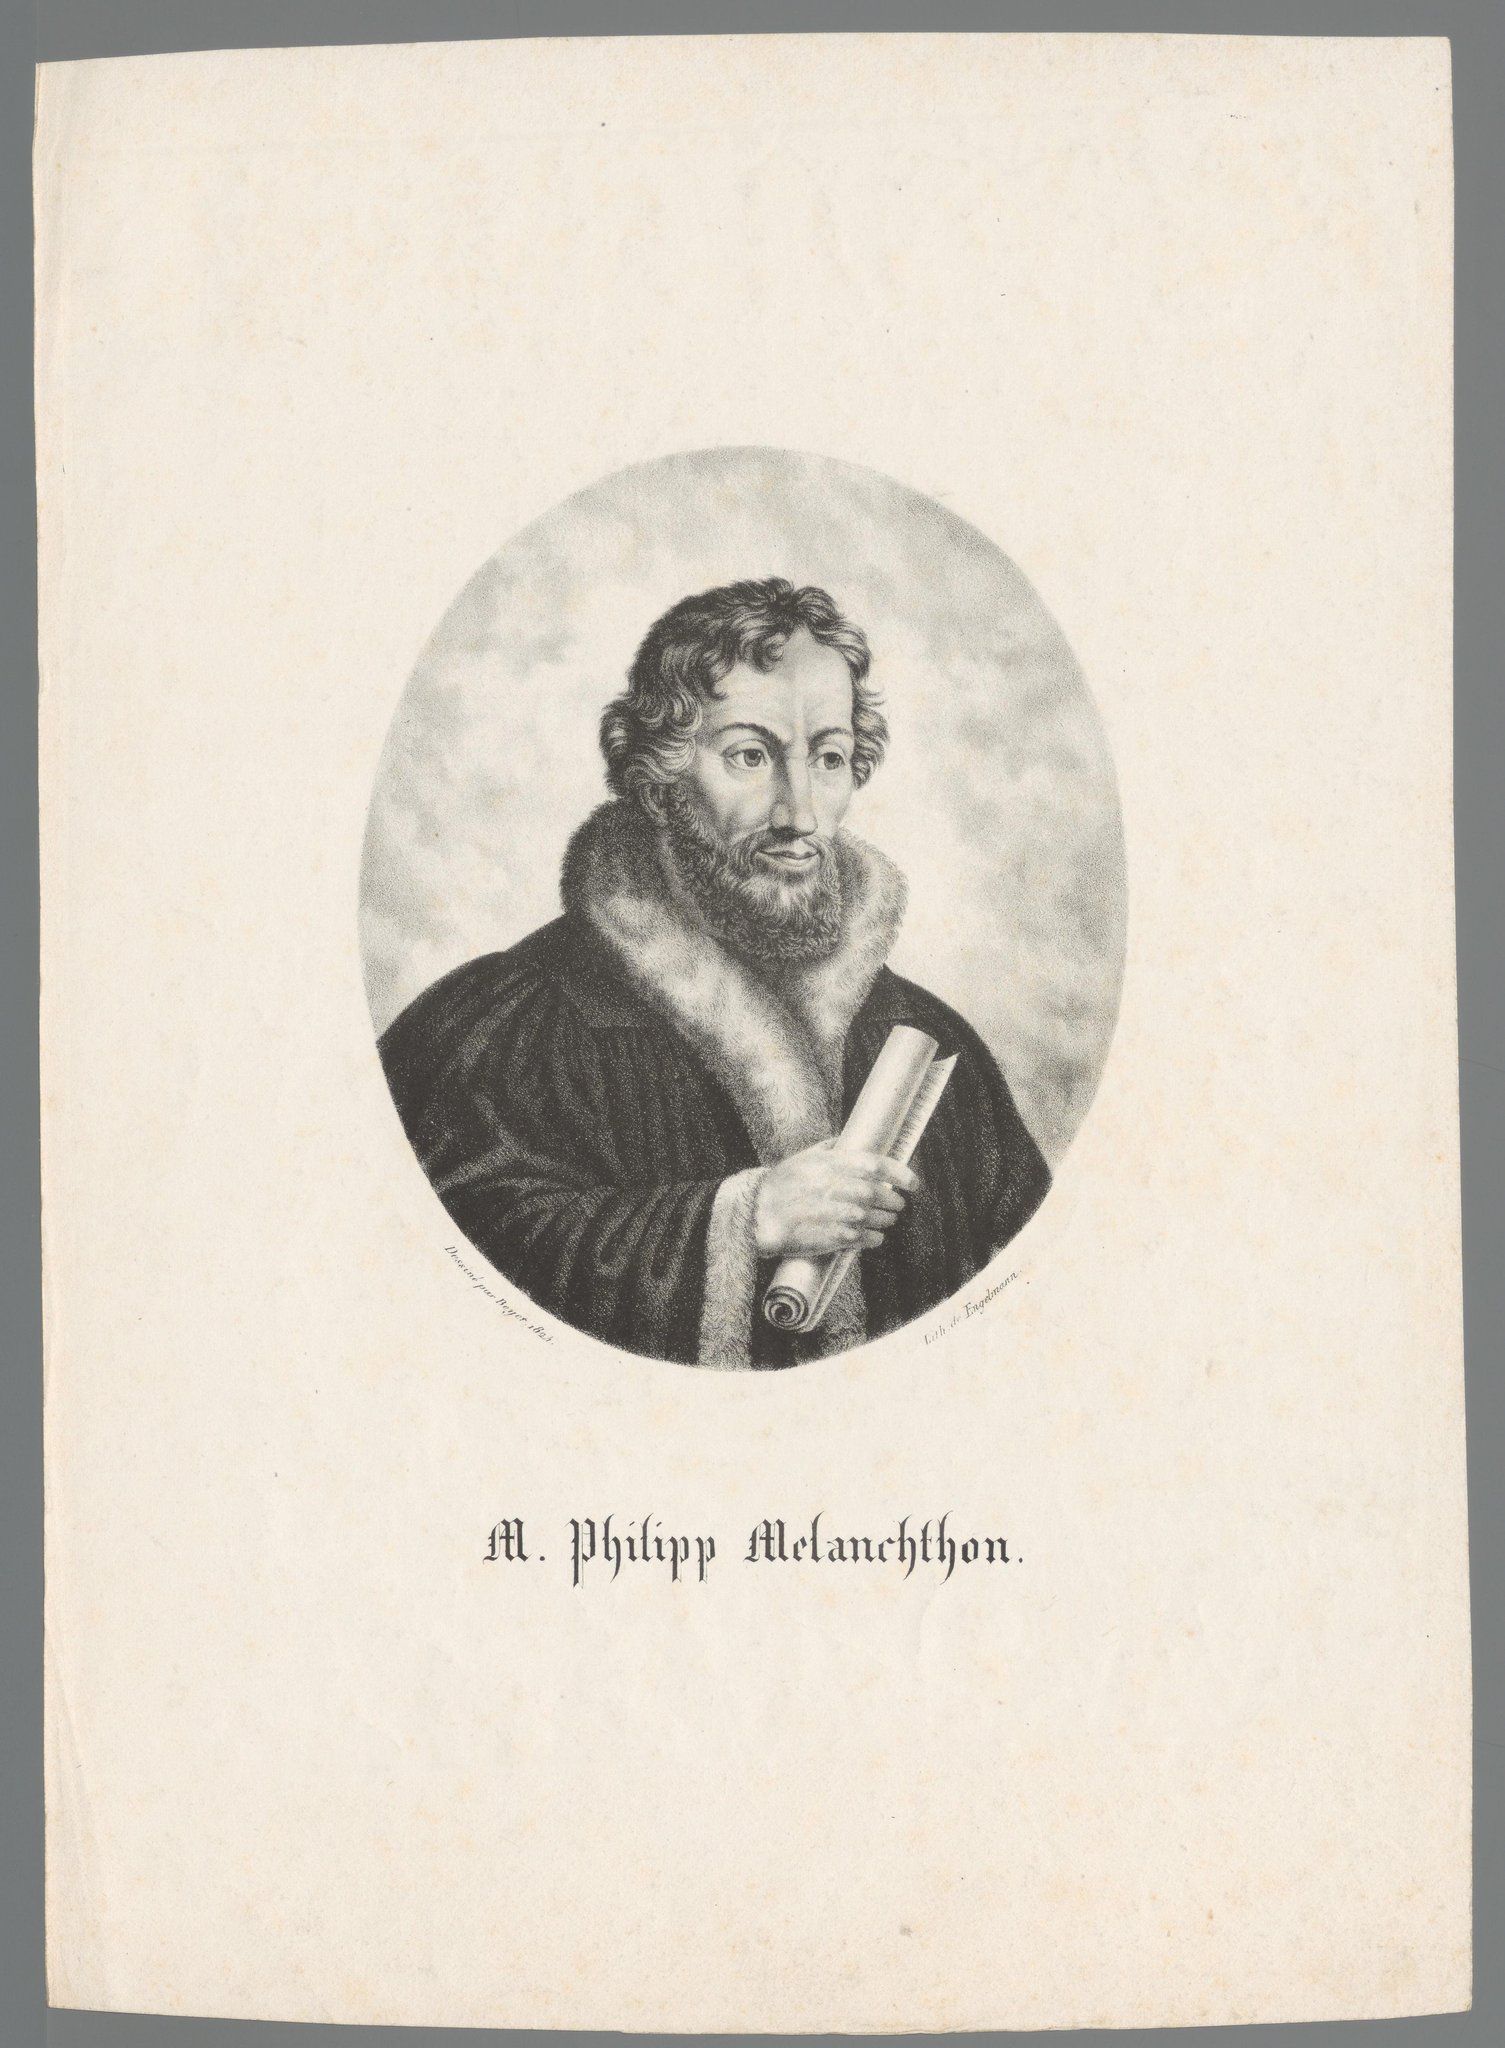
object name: print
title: Portret van Philipp Melanchthon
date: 1824-1880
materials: paper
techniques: lithograph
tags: adult man, historical persons, scroll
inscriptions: collector's mark: Lugt 2228